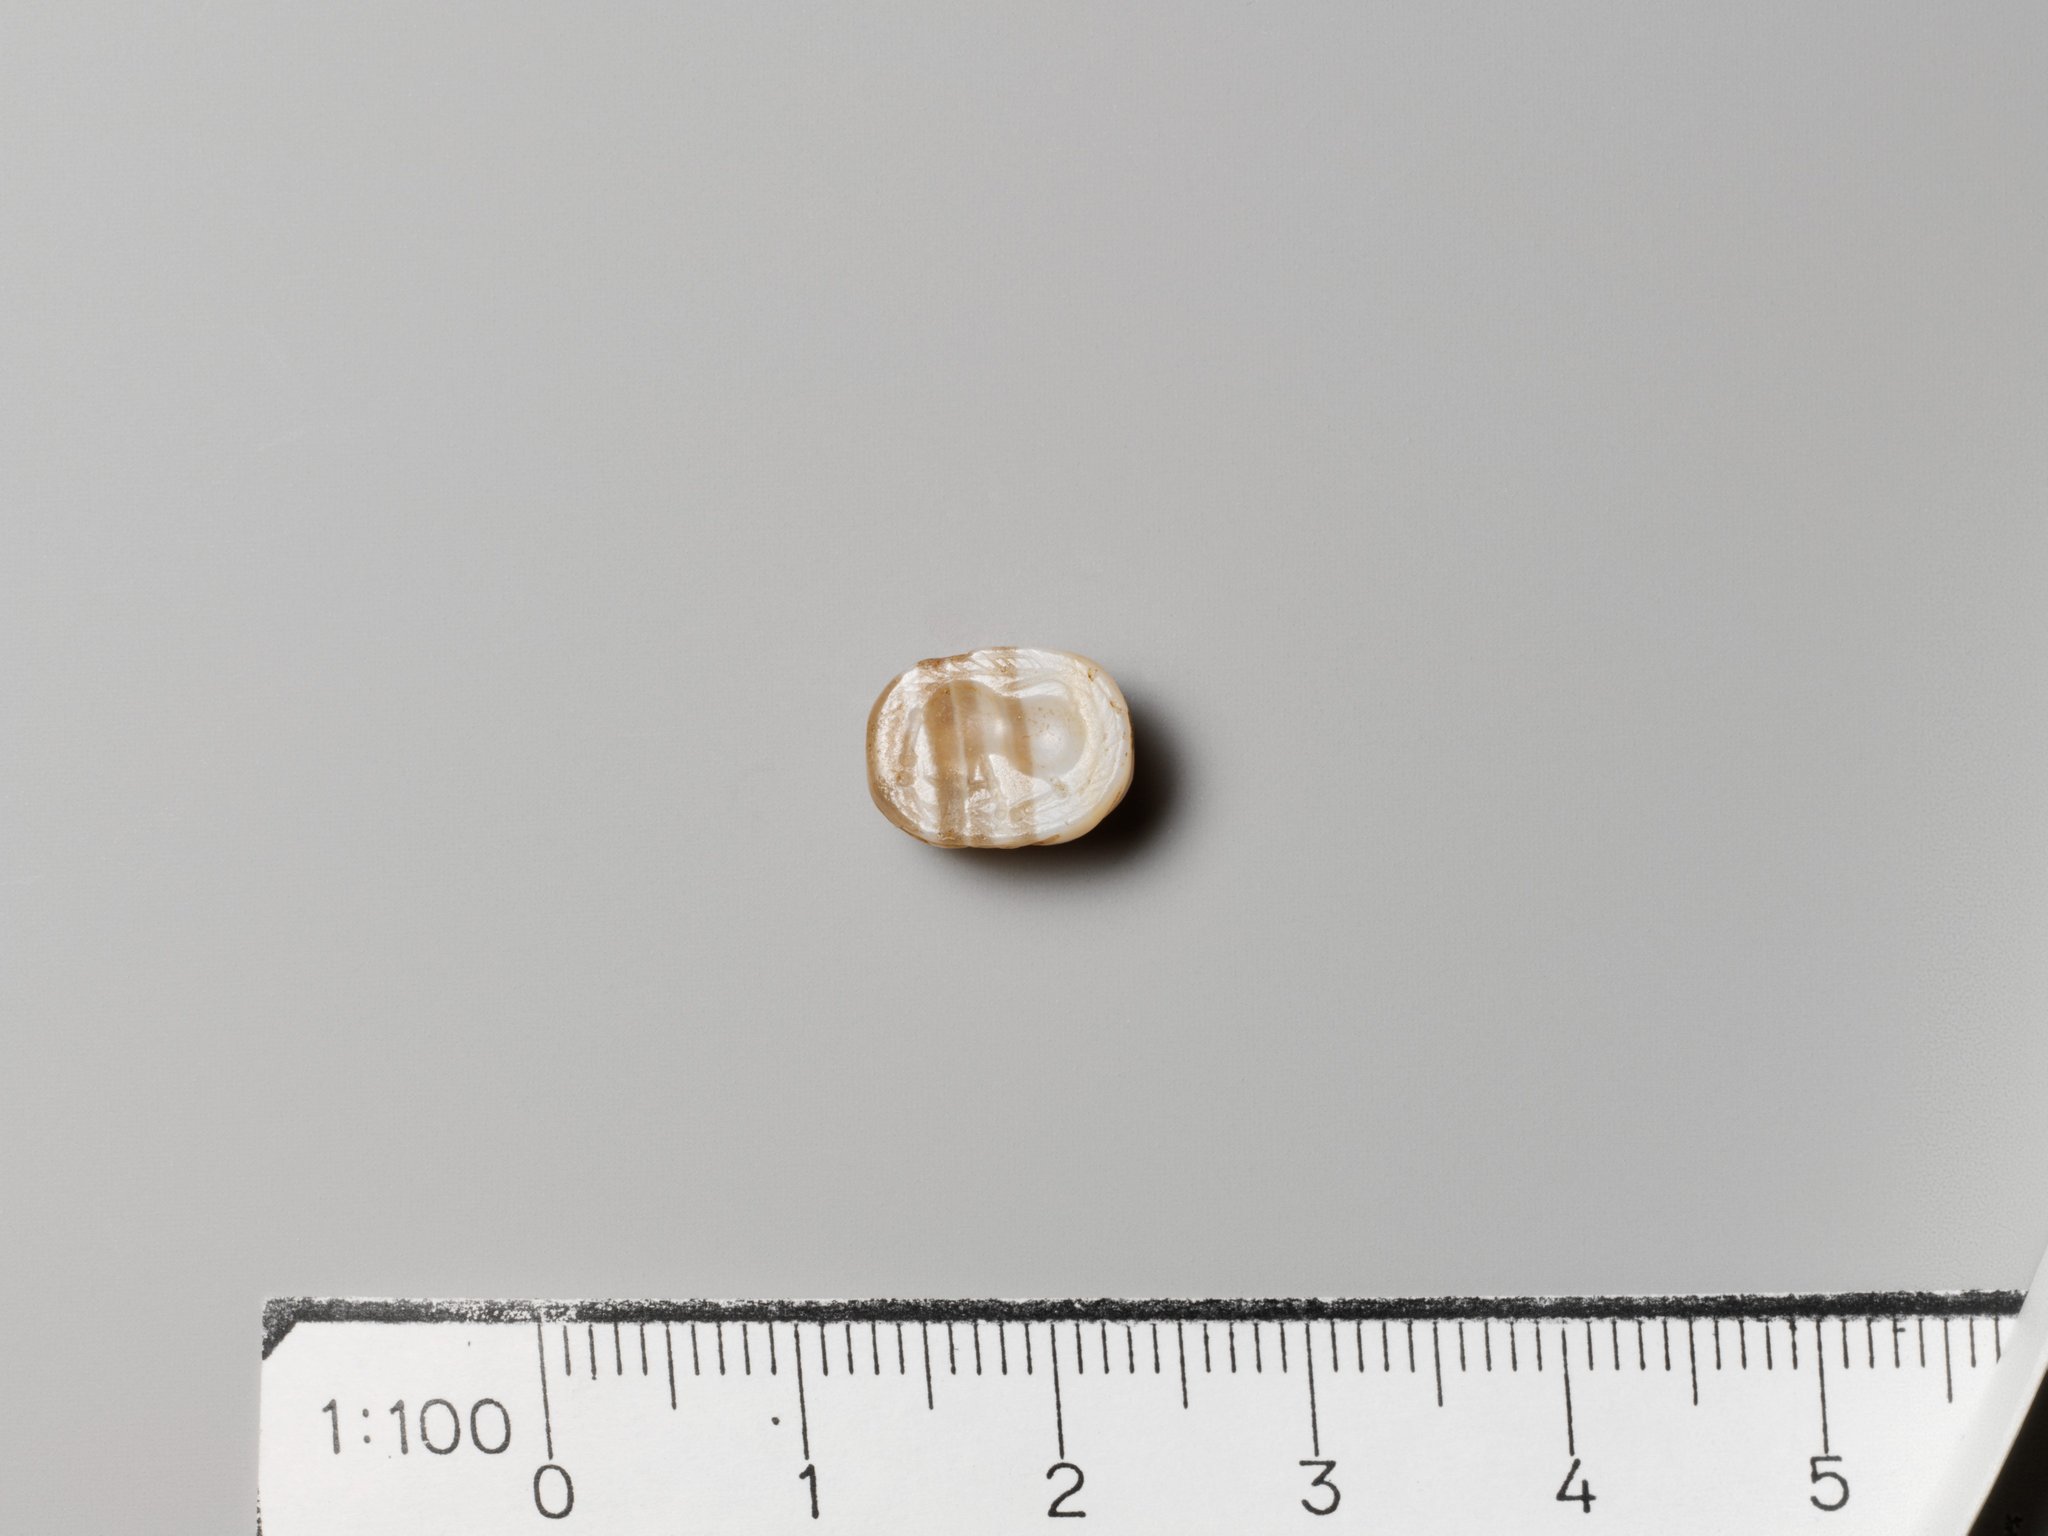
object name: scarab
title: Carnelian scarab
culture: etruscan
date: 300-201 BCE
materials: gemstone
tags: bulls,scarabs